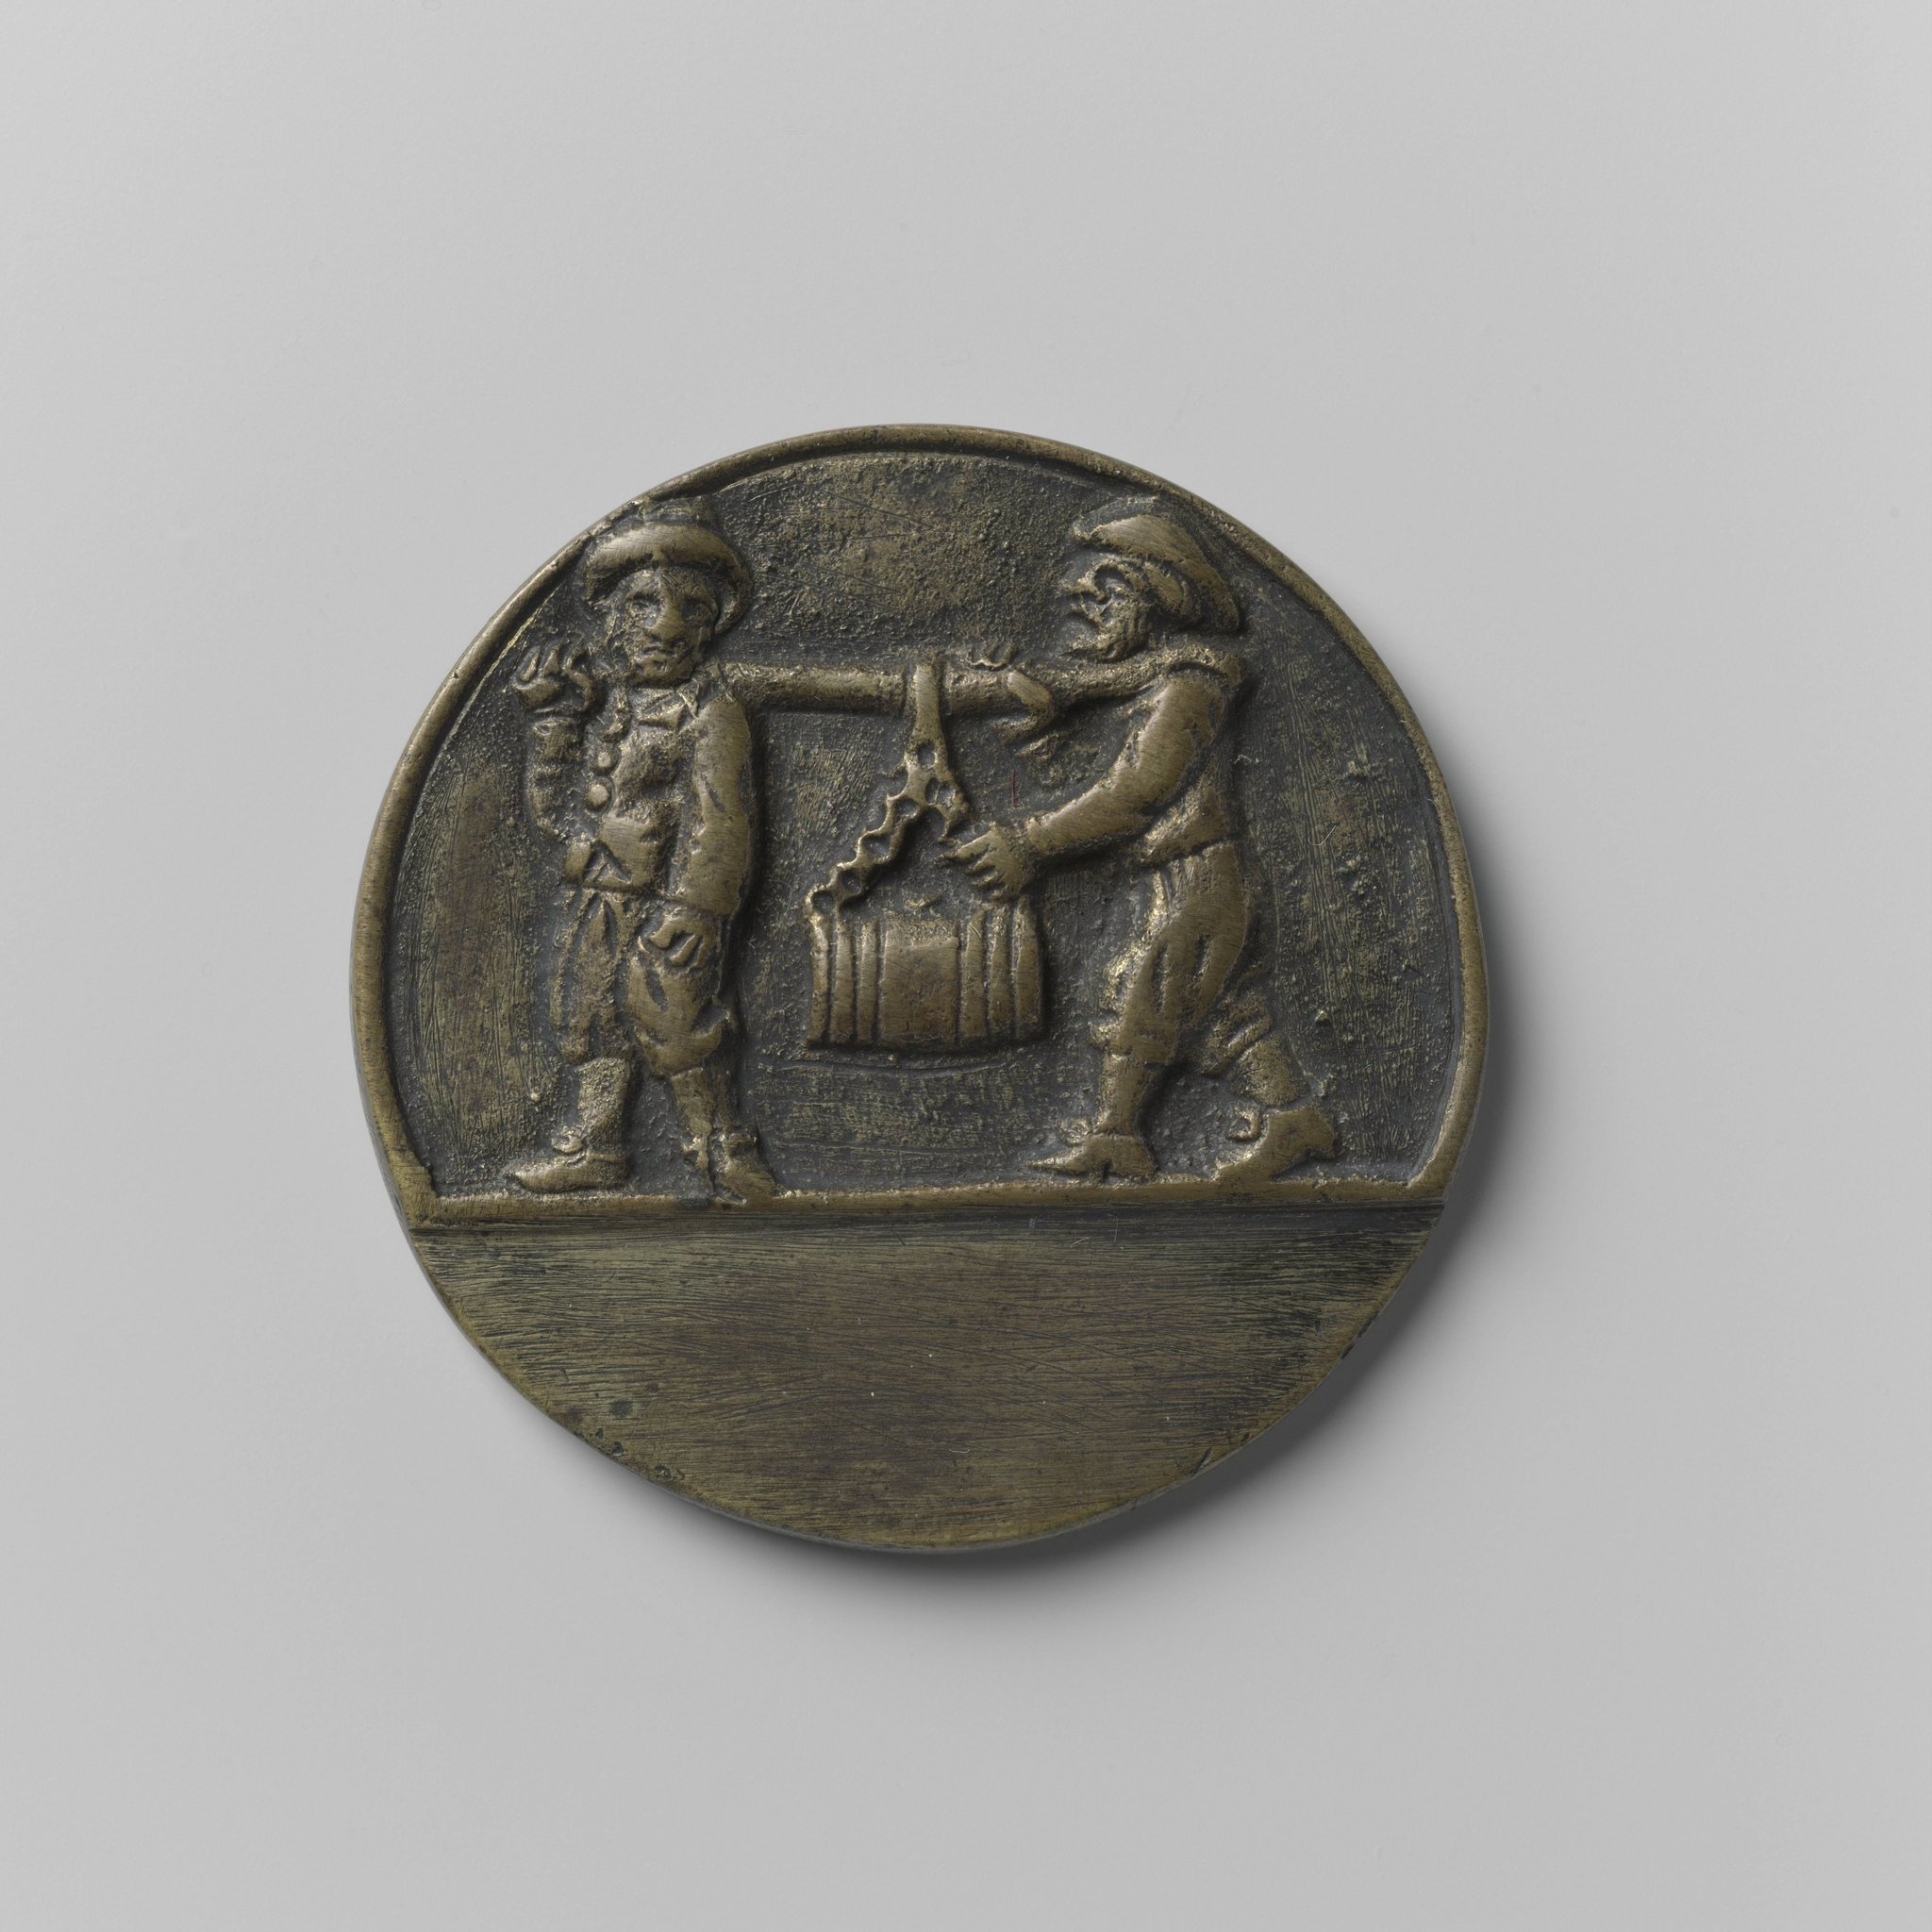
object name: medal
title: Bierdragersgilde van Amsterdam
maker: Anonymous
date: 1665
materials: brass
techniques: casting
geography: amsterdam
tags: amsterdam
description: Messing penning. Voorzijde: staande vrouw met een tak hop in haar opgeheven rechterhand en een schild met daarop een draagberrie in de linkerhand, binnen omschrift. Keerzijde: twee mannen met een draagstok waaraan een vat hang. De afsnede is leeg.